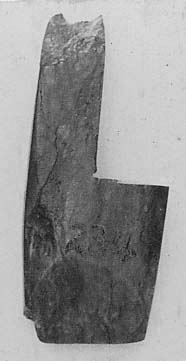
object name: chisel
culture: canadian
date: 1902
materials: jade